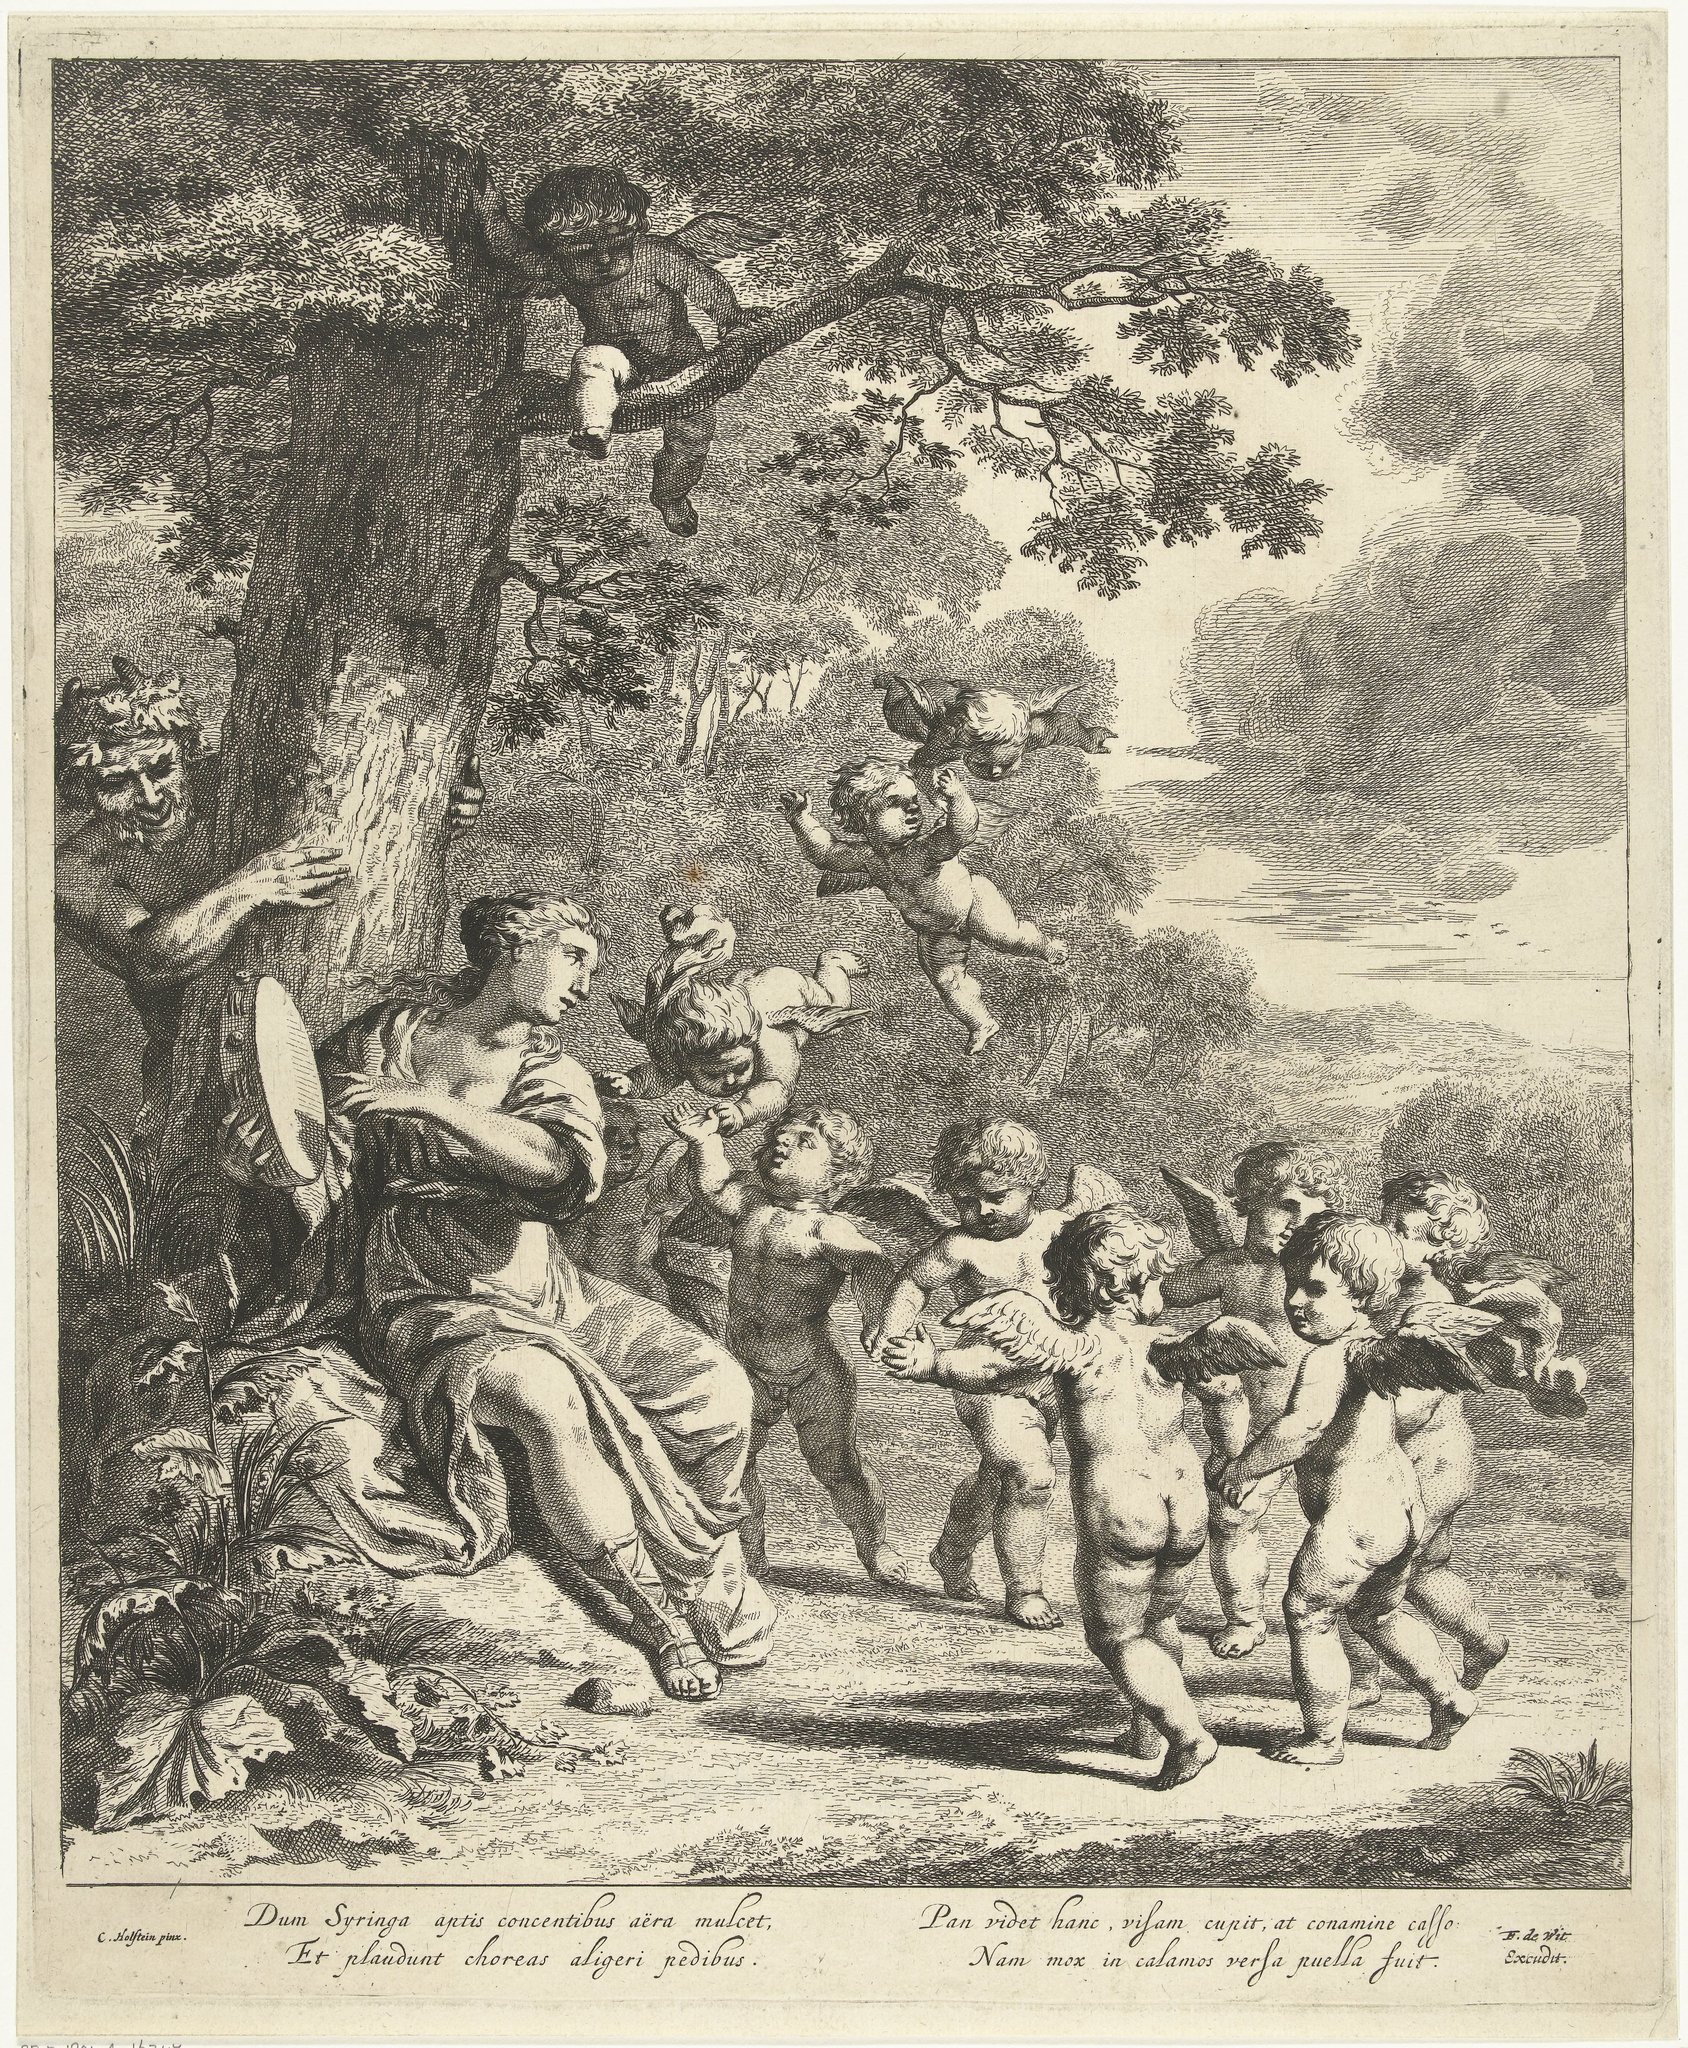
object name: print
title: Pan en Syrinx met dansende putti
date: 1633-1666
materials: paper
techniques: etching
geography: amsterdam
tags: (story of) pan, cupids: 'amores', 'amoretti', 'putti', single named nymphs (with name)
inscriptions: collector's mark: Lugt 2228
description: Cat. de Ridder, nr. 255. Prent naar schilderij van Cornelis Holsteyn.